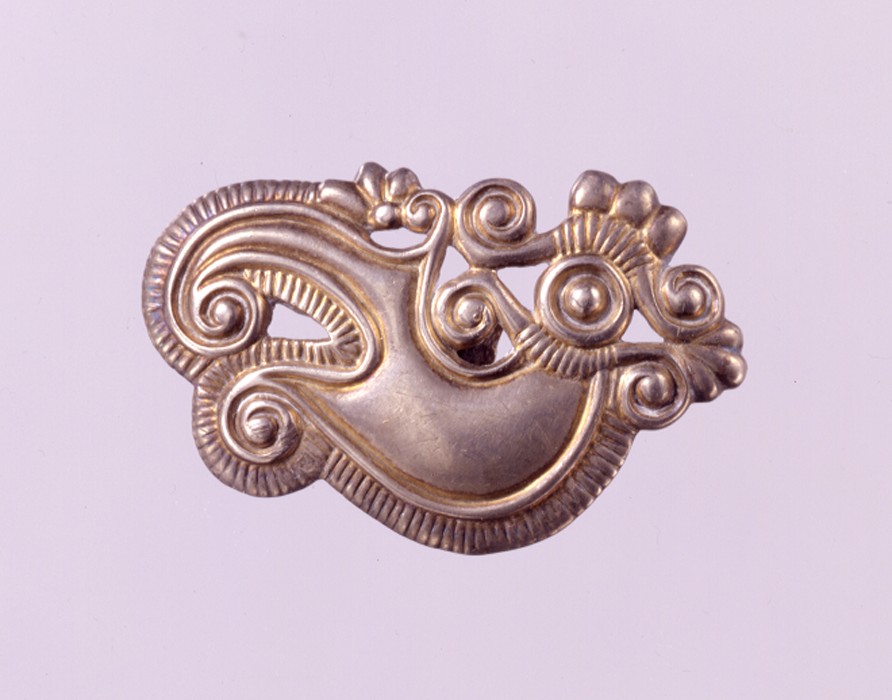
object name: harness ornament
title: Harness Ornament with Raptors and Carnivores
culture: bulgarian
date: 434-301 BCE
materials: silver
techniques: gilding